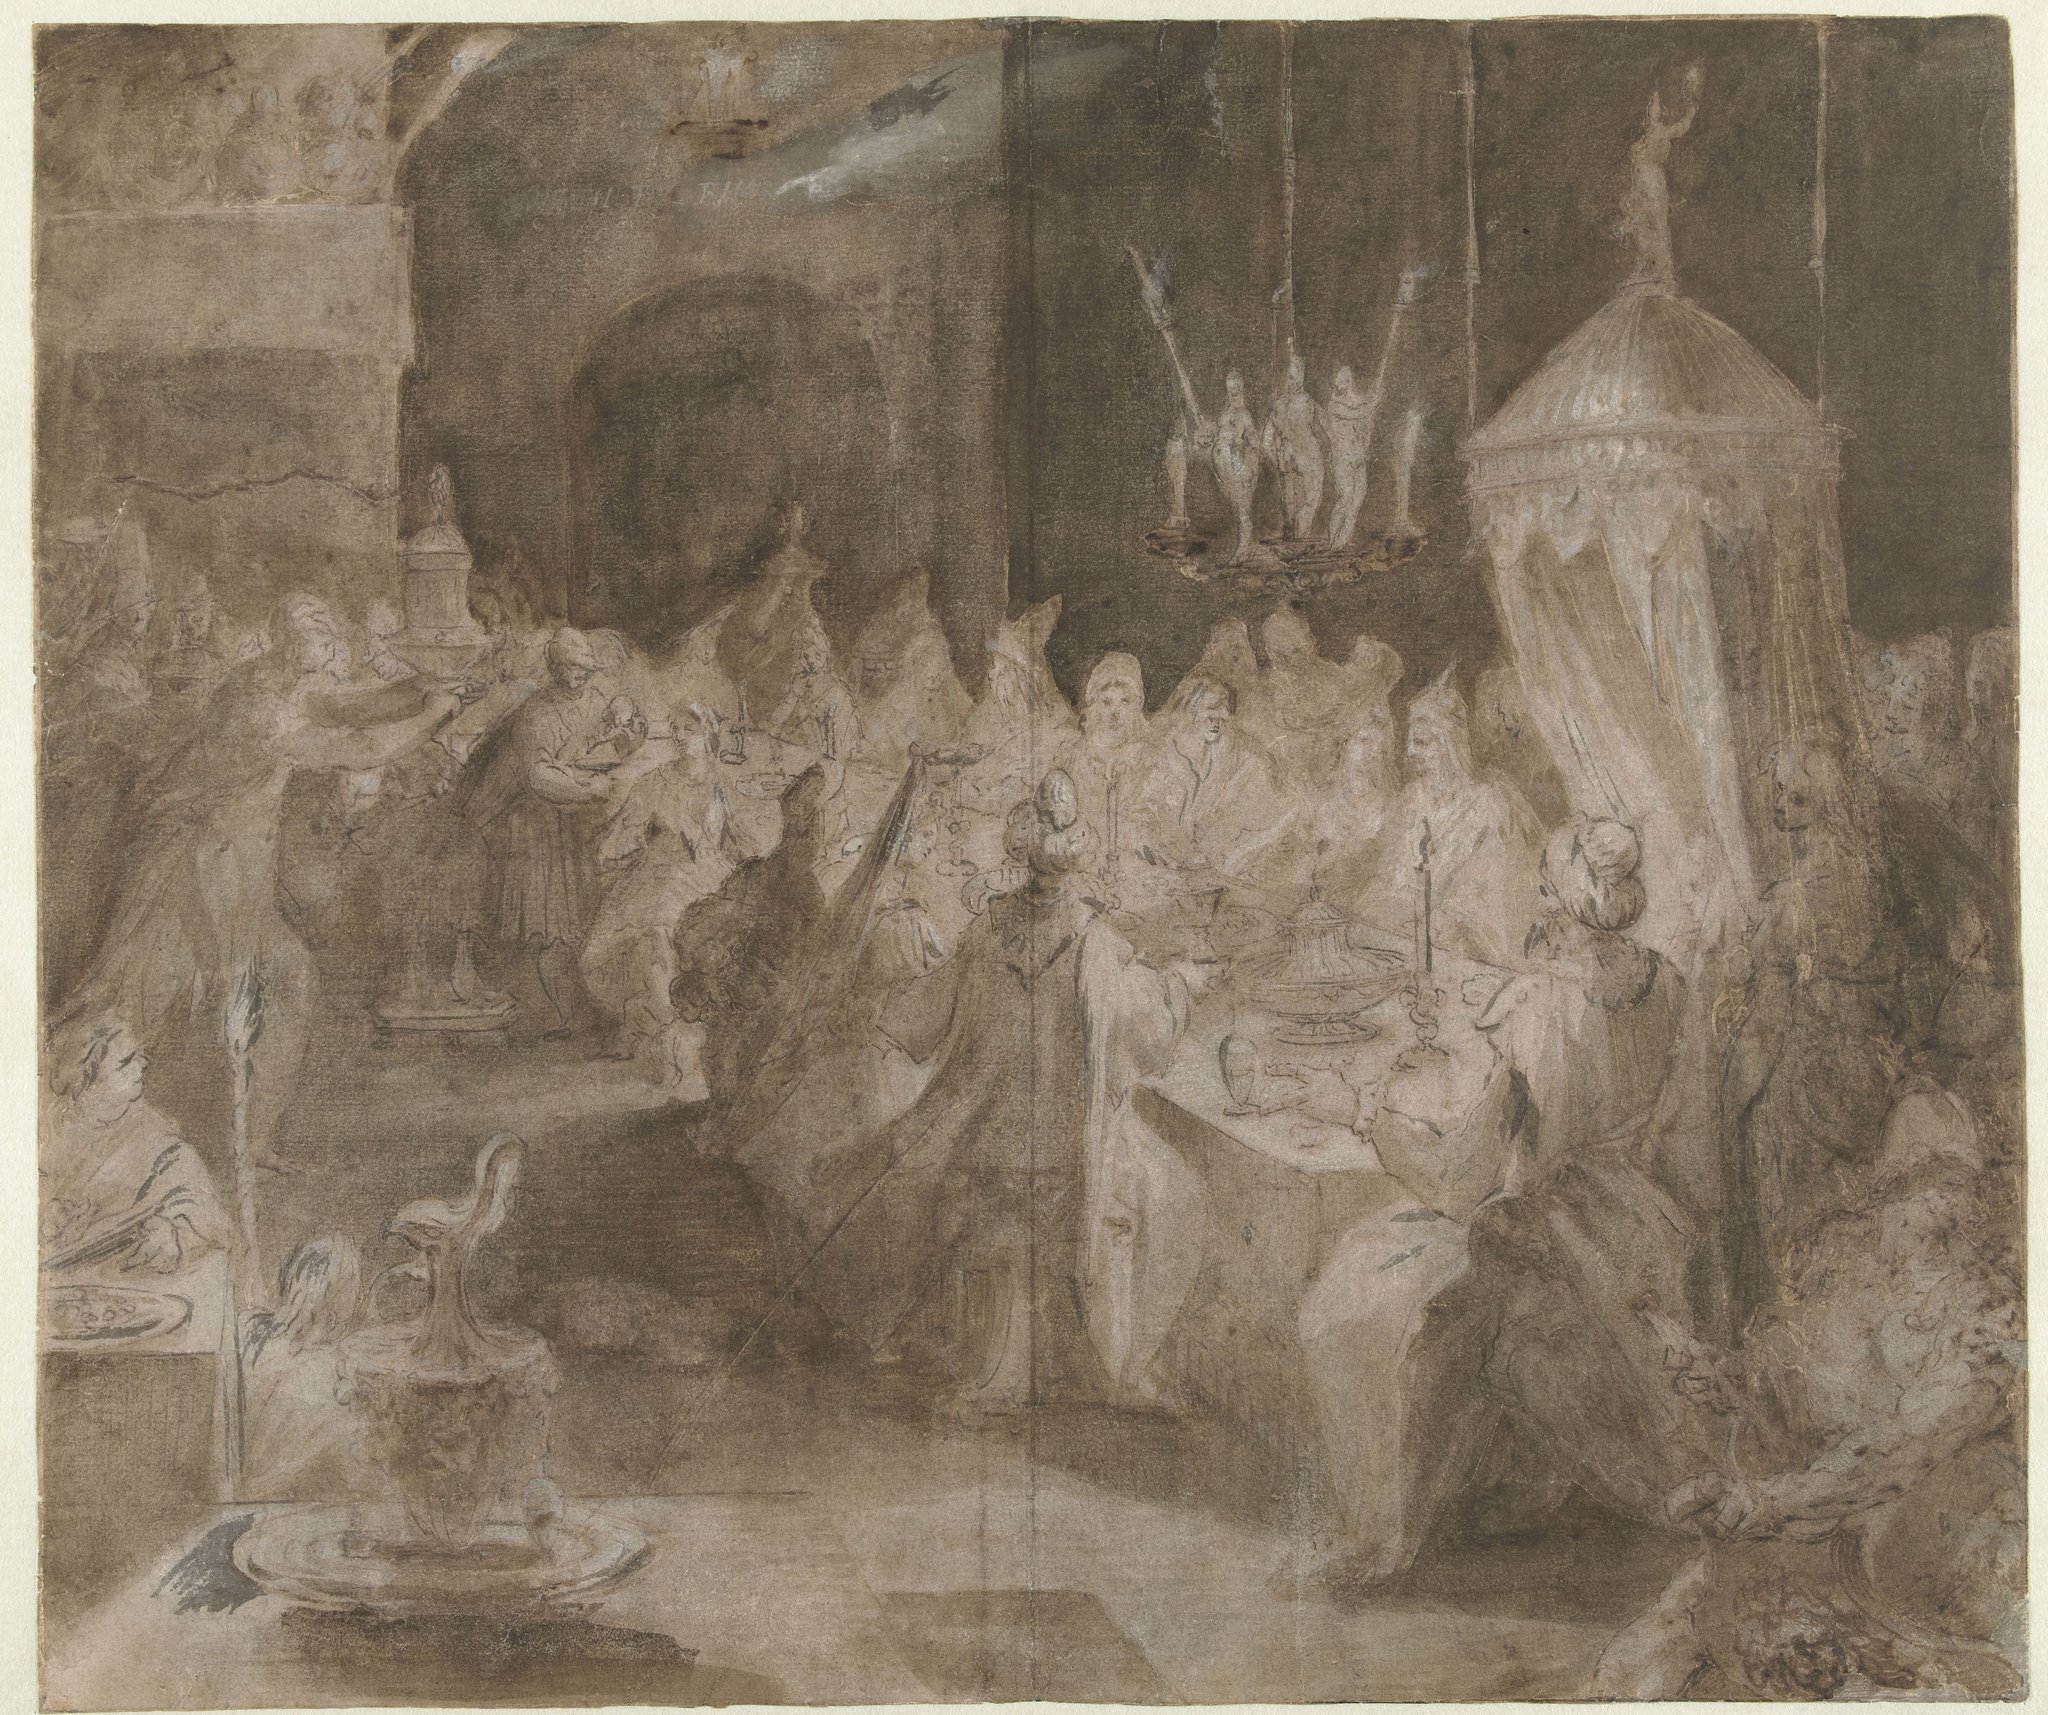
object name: design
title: Het gastmaal van Belsassar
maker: jan harmensz. muller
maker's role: draughtsman, print maker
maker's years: 1571-1628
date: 1588-1595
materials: ink, paint, paper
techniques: brush, pen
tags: during belshazzar's banquet a hand appears and writes on the wall (mene, mene, tekel and parsin (upharsin)); king belshazzar is frightened